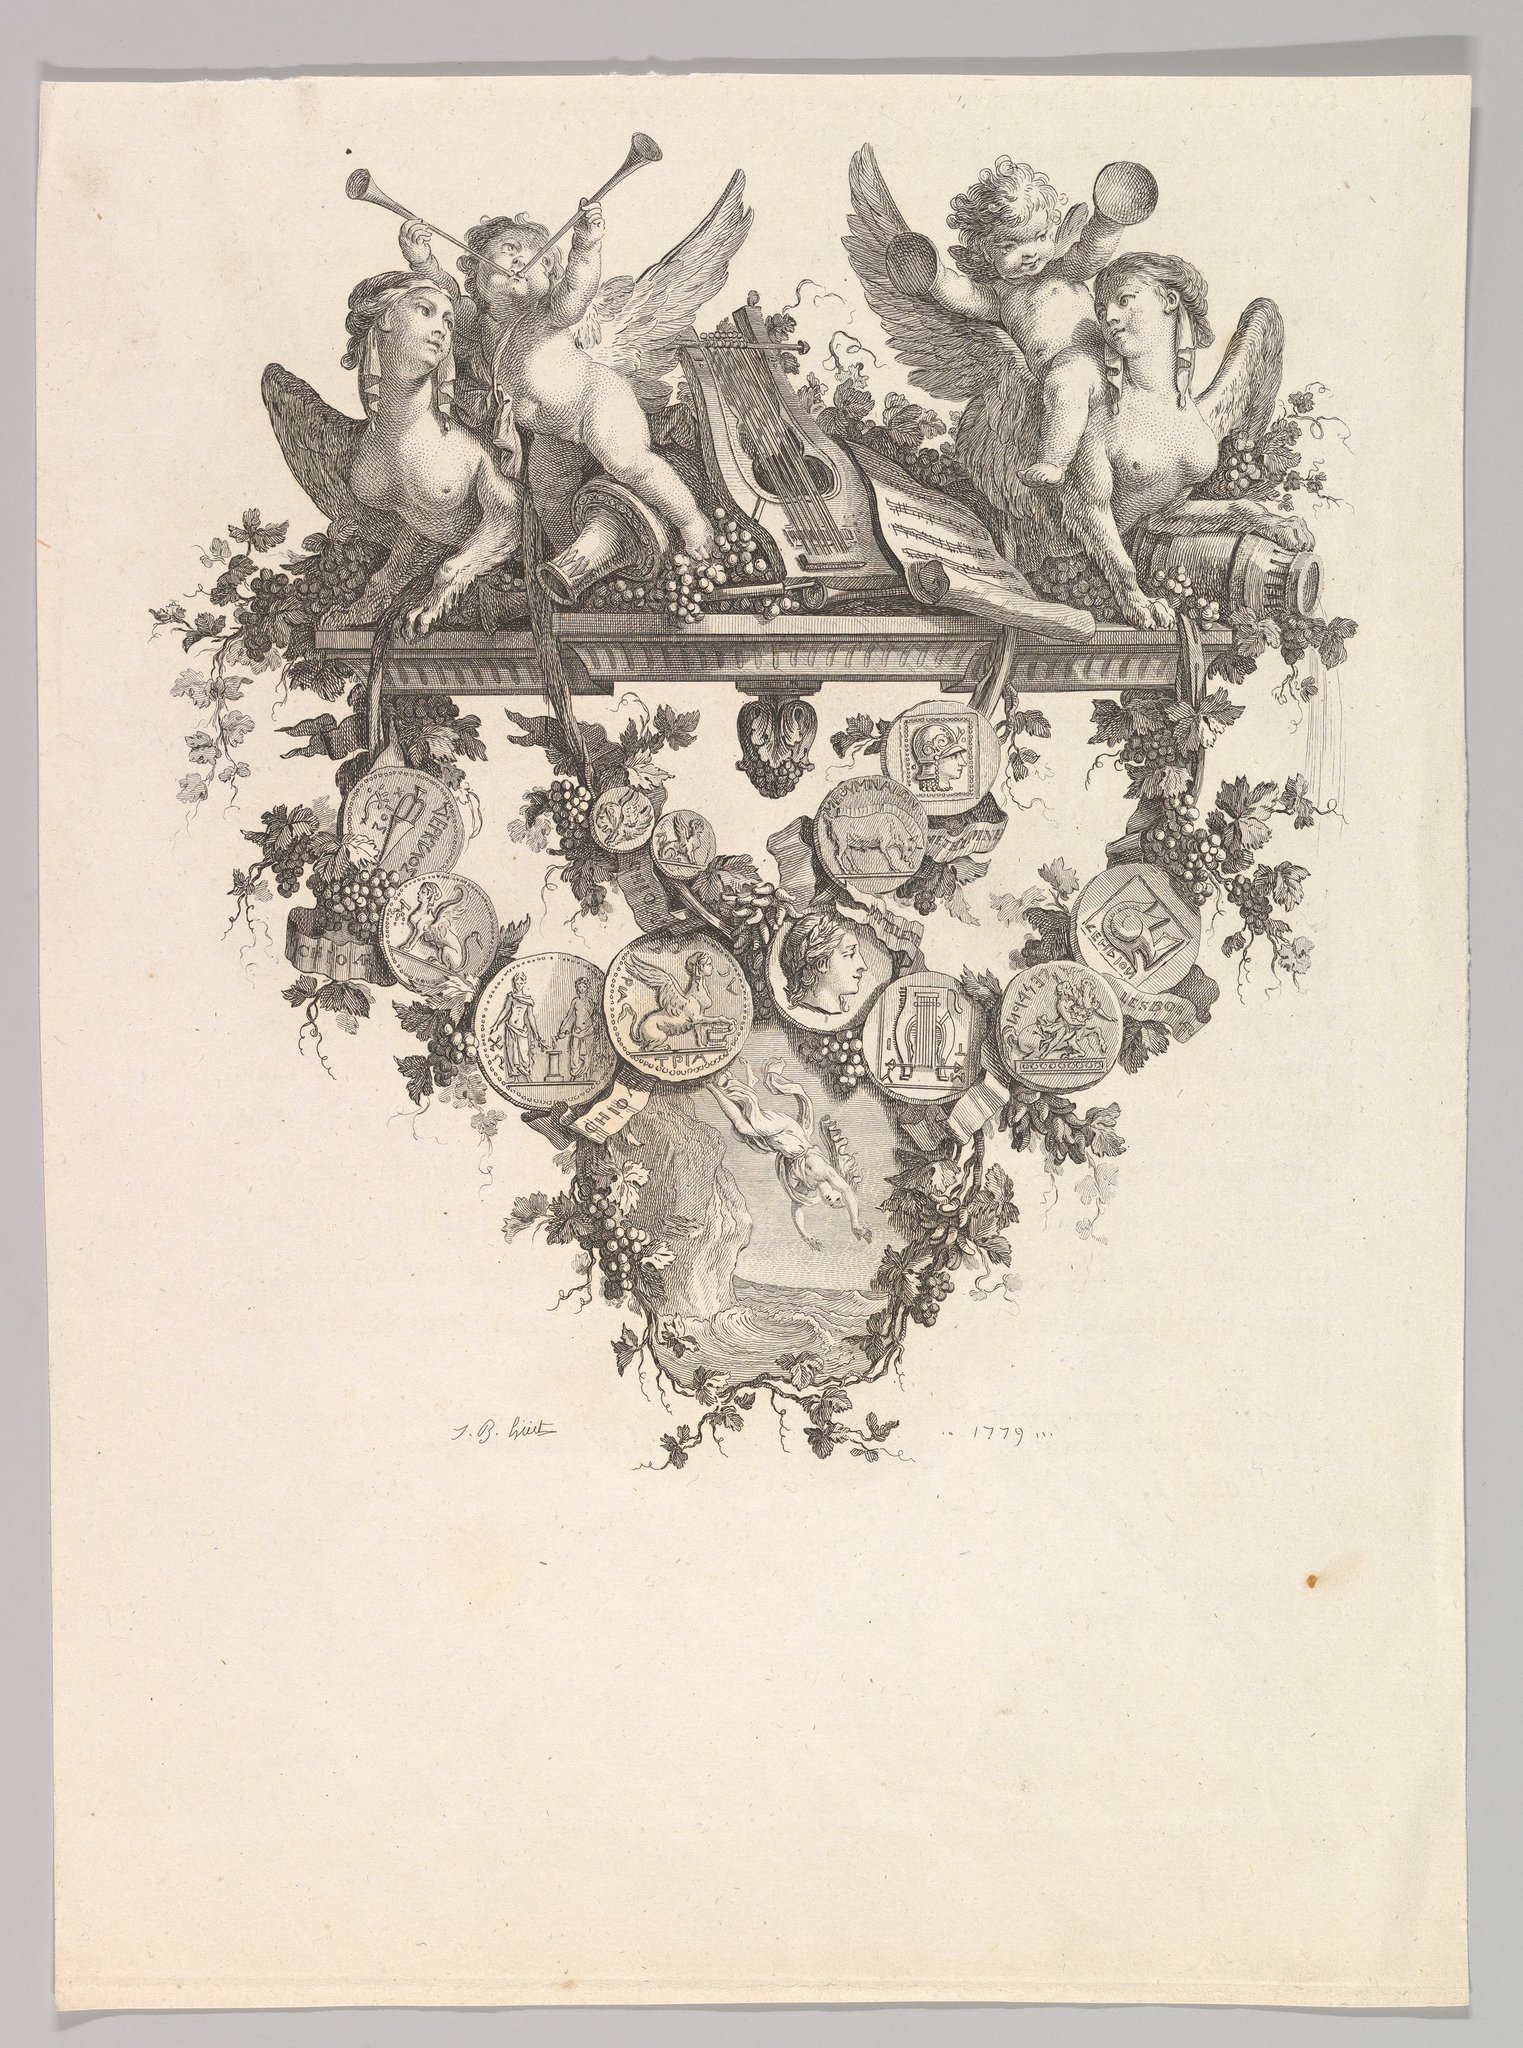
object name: print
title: Vignette with Sphinxes and Putti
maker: jean-baptiste huet i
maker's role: artist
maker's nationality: french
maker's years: 1745-1811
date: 1779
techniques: etching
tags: sphinx,putti